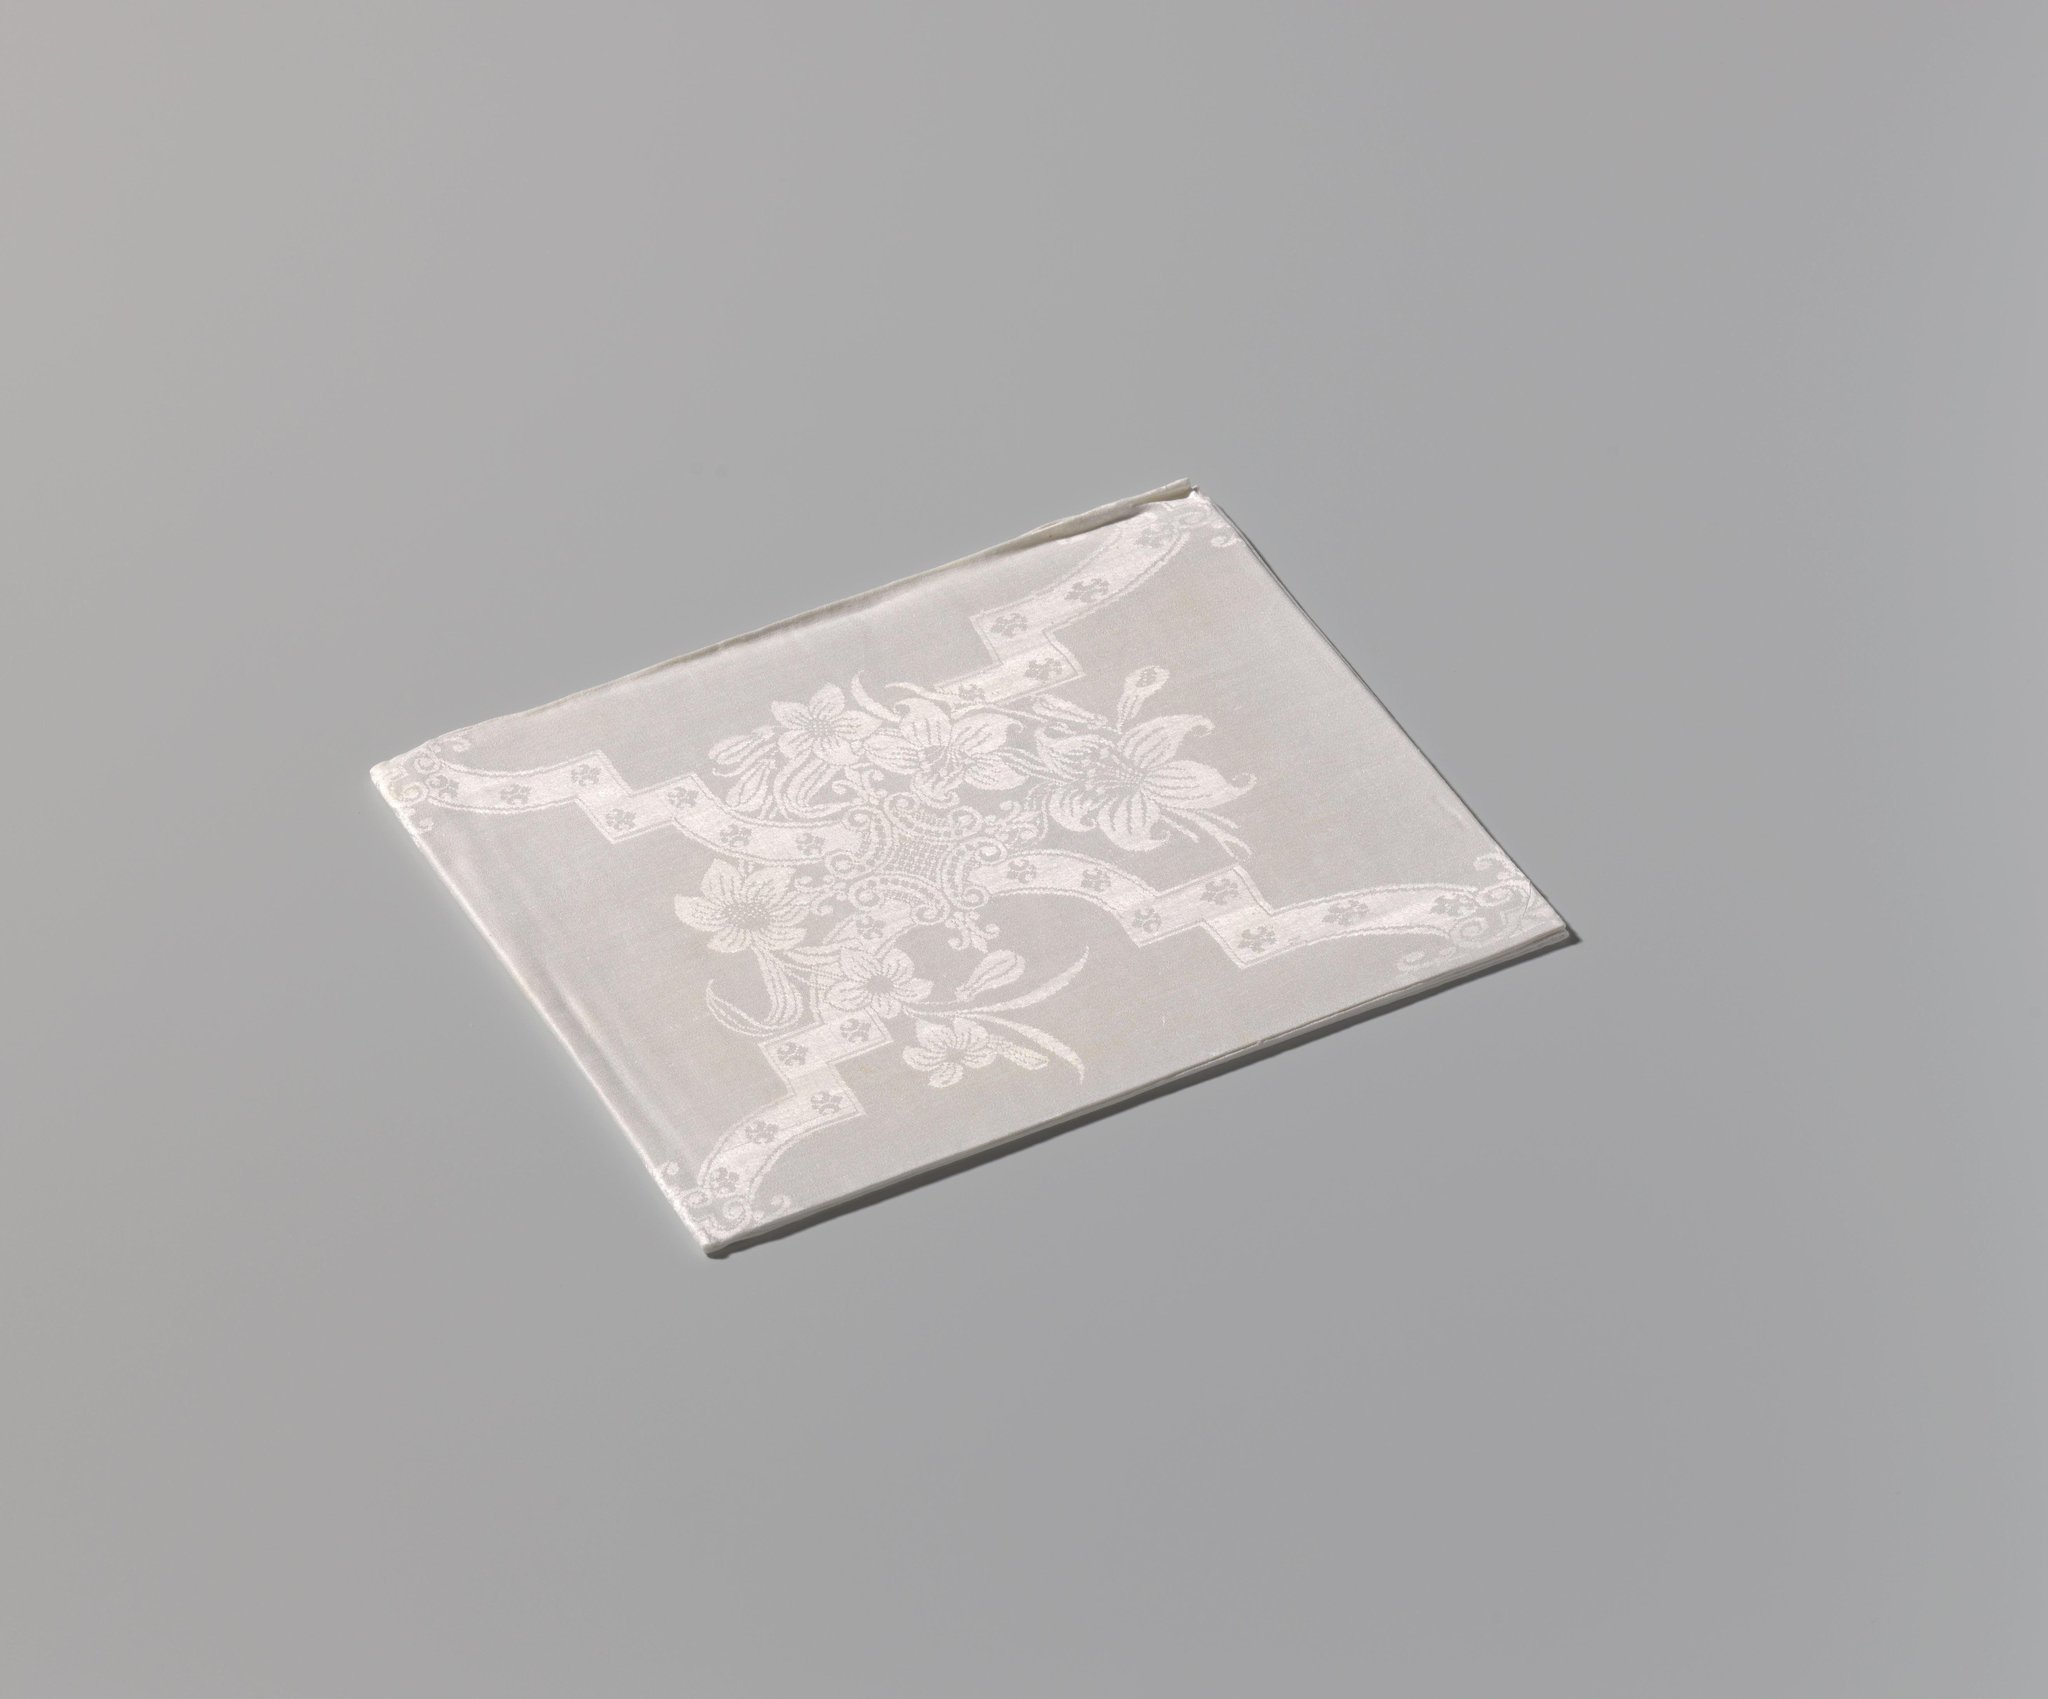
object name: napkin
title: Servet met fleurs de lys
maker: Anonymous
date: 1700-1710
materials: linen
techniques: damask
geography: dresden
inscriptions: label: ‘R.M. A'dam’, mark: ‘BLS’, mark: ‘24’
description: Servet van linnendamast met fleurs de lys. Slingerende banden vormen in de hoogte gerekte velden. De banden bestaan uit rechte en ronde delen, gevuld met kleine fleurs de lys; op de raakpunten een slingerende tak met leliën. De rand, alleen aan de buitenzijde omlijnd met fijne zigzagzomen en rolwerk met rastervulling, vertoont dicht aaneengesloten bloemboeketten, in de hoeken naar het midden gericht en voortkomend uit een draagstuk, waarop een fleur de lys. Rondom: blokkenrand.